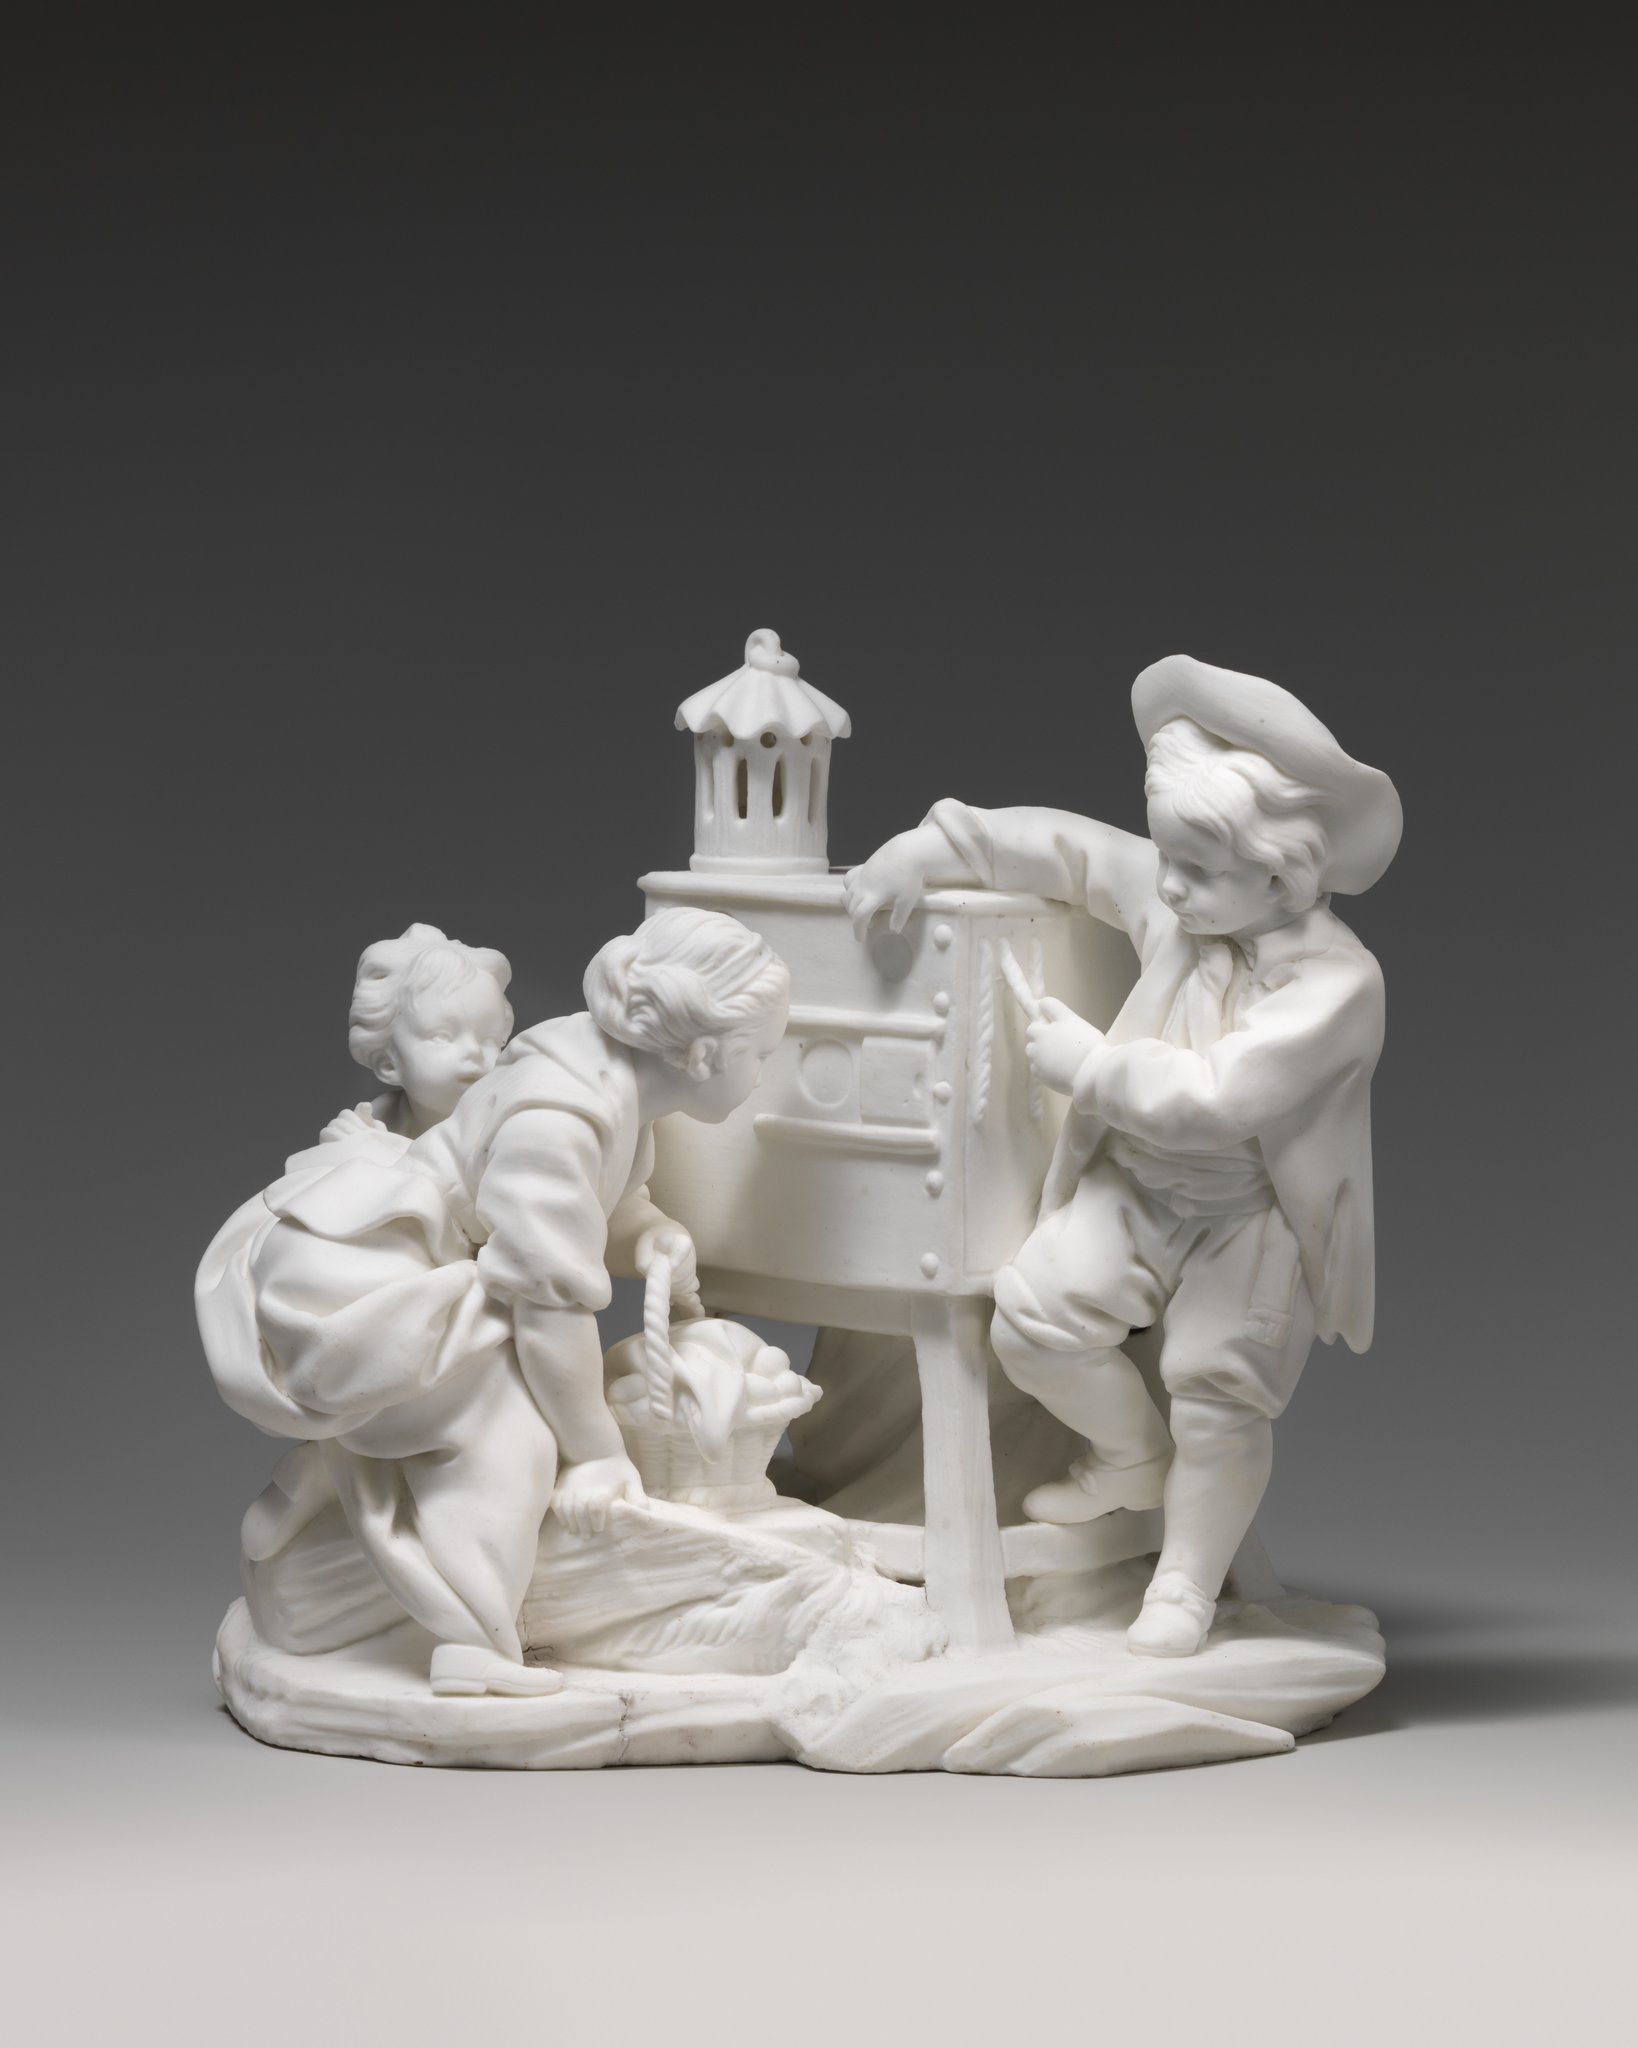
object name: group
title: The Magic Lantern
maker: sèvres manufactory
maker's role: manufactory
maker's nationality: french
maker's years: 1740-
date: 1760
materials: biscuit, paste, porcelain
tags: boys,girls,lanterns